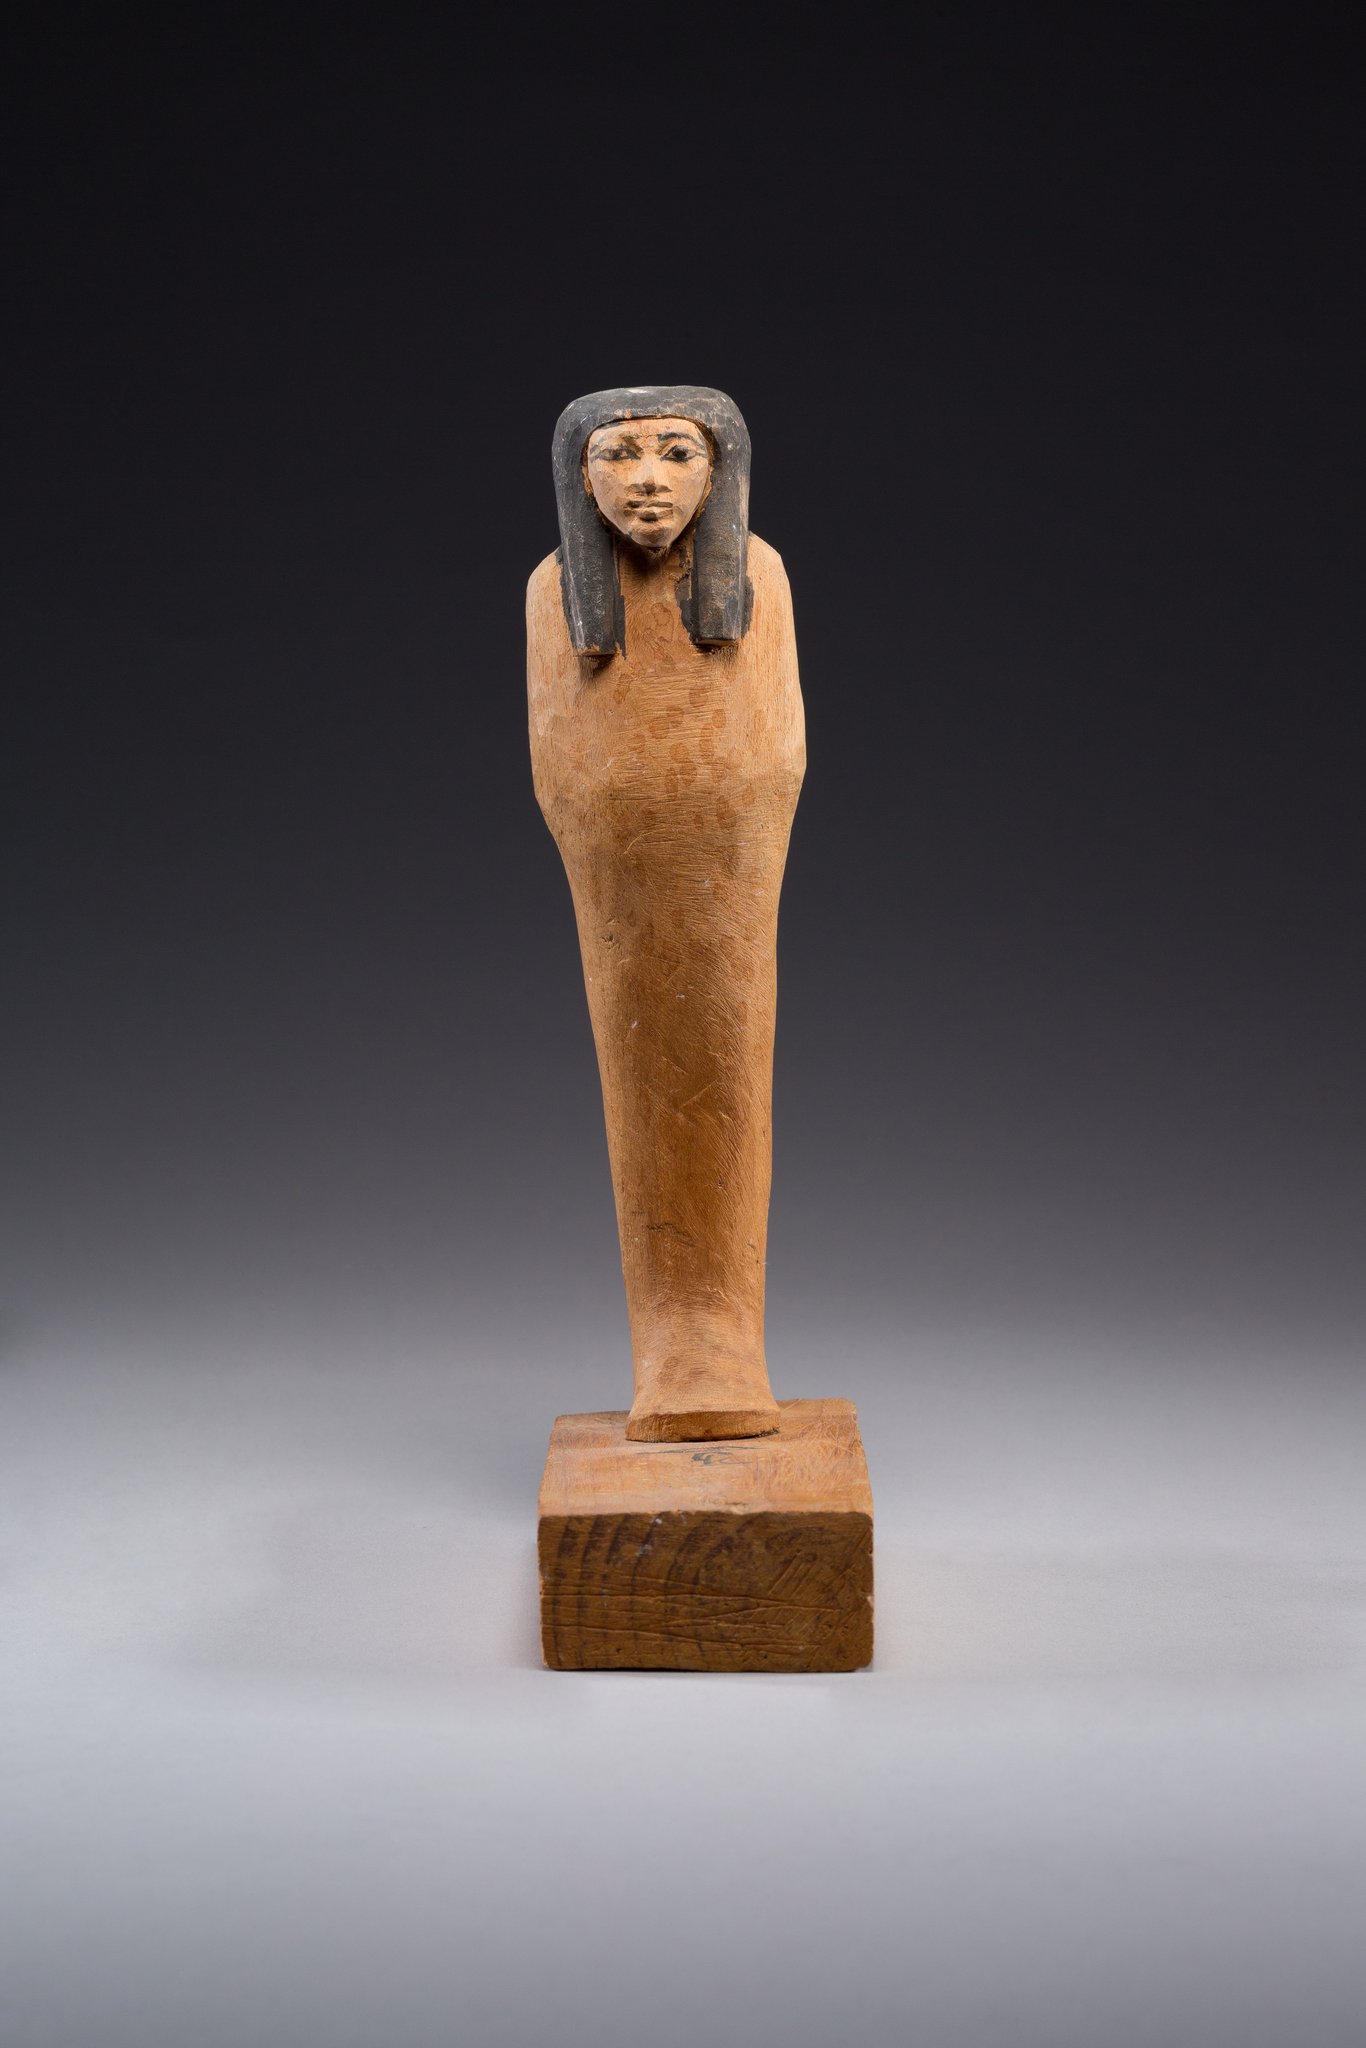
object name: funerary figure, osiride, iry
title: Osirid Figure of Iry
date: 1479-1458 BCE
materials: paint, wood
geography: egypt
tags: kings